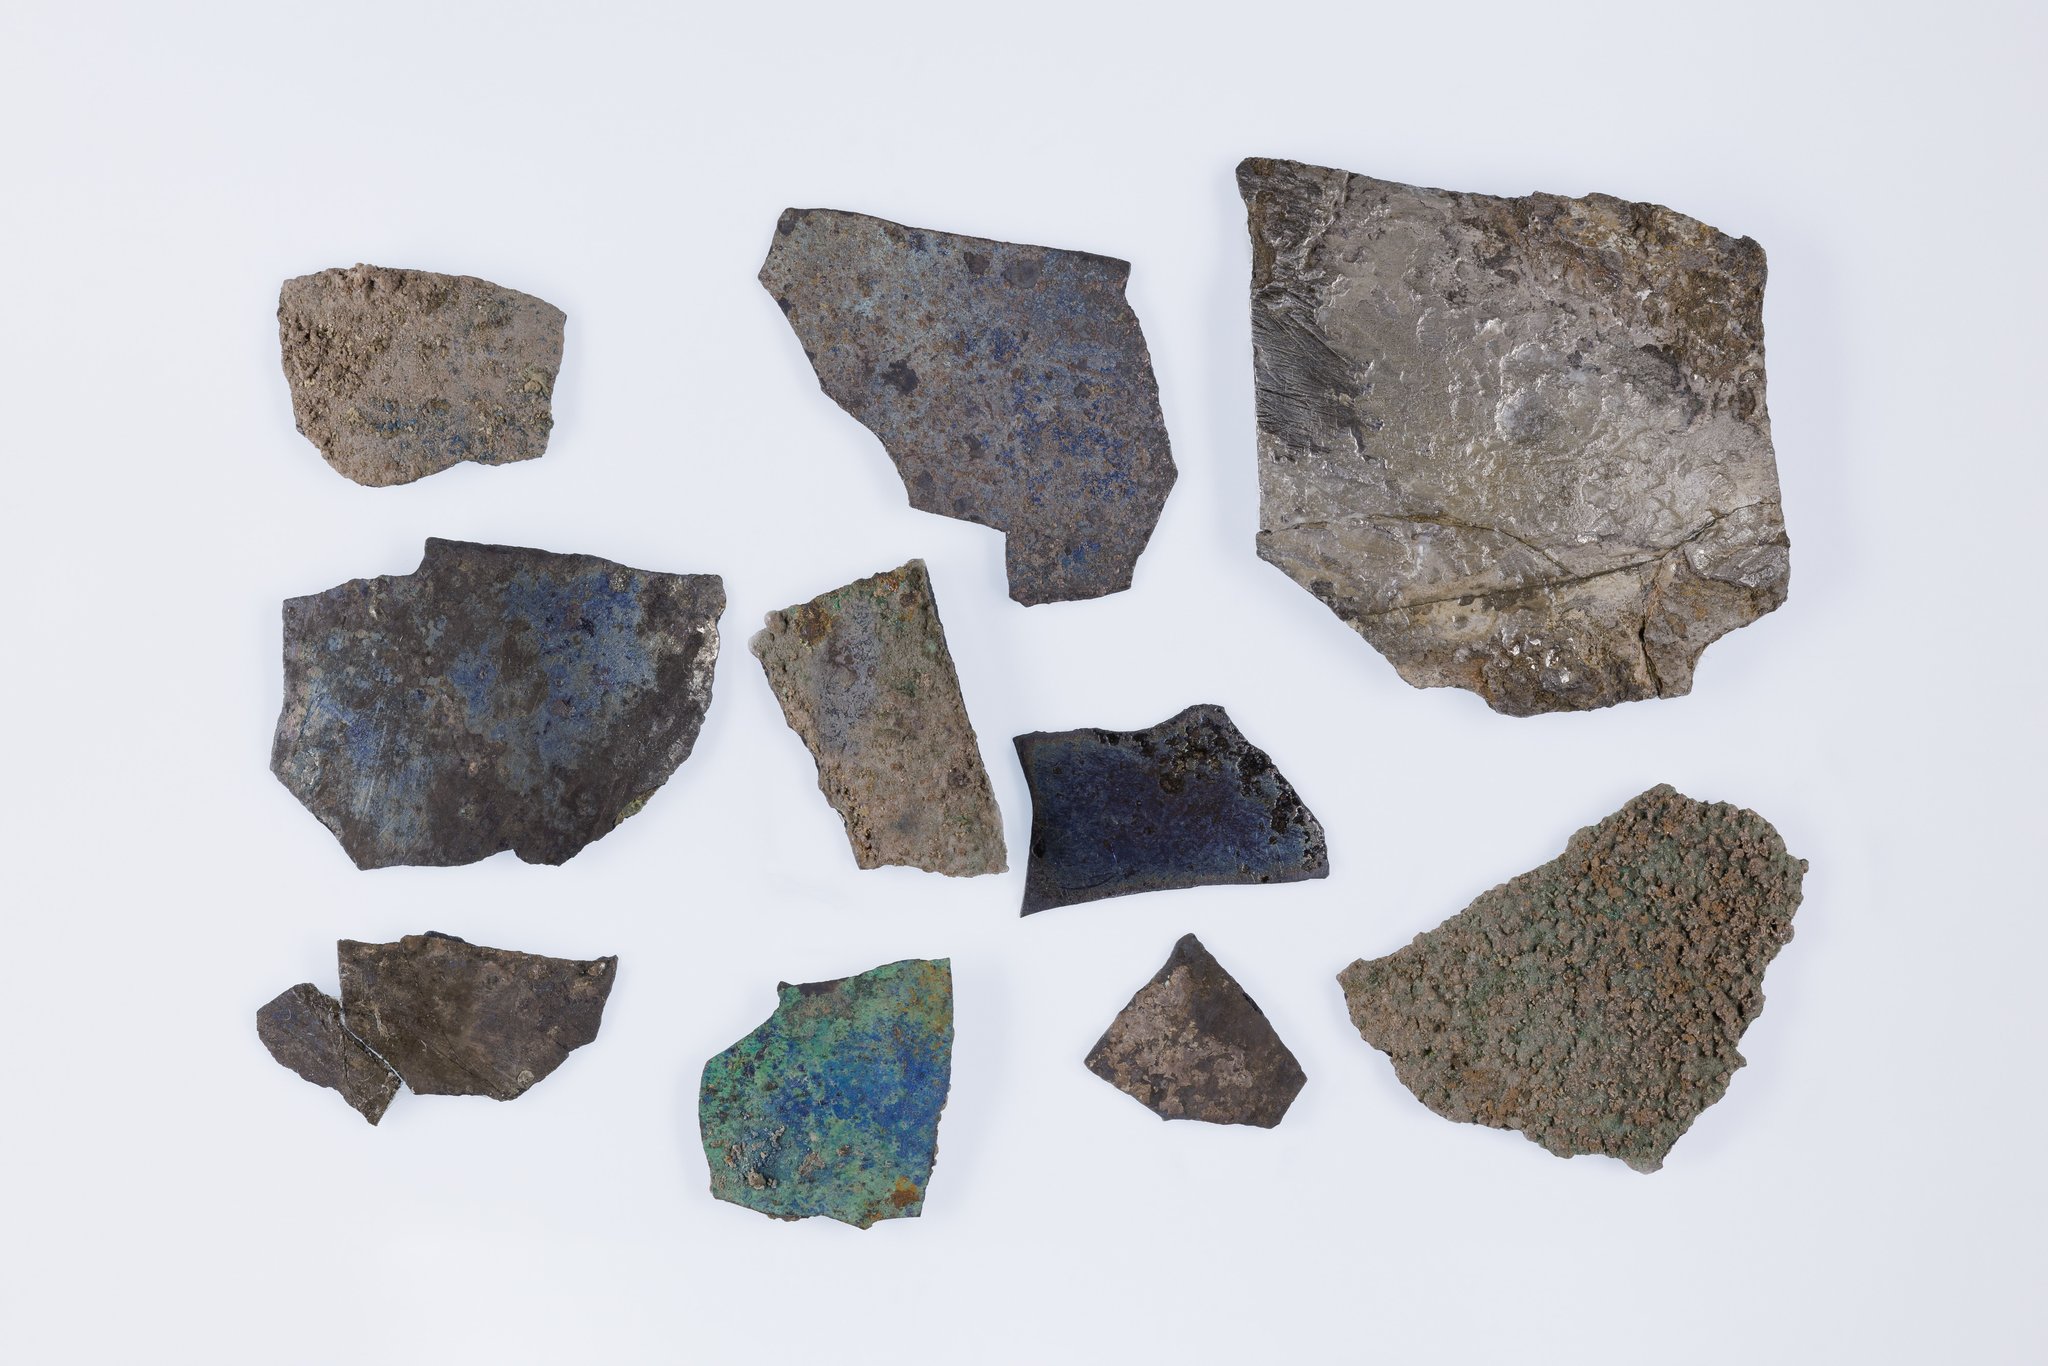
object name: vessel fragment, tell basta treasure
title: Vessel fragments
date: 1070-712 BCE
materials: silver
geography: egypt